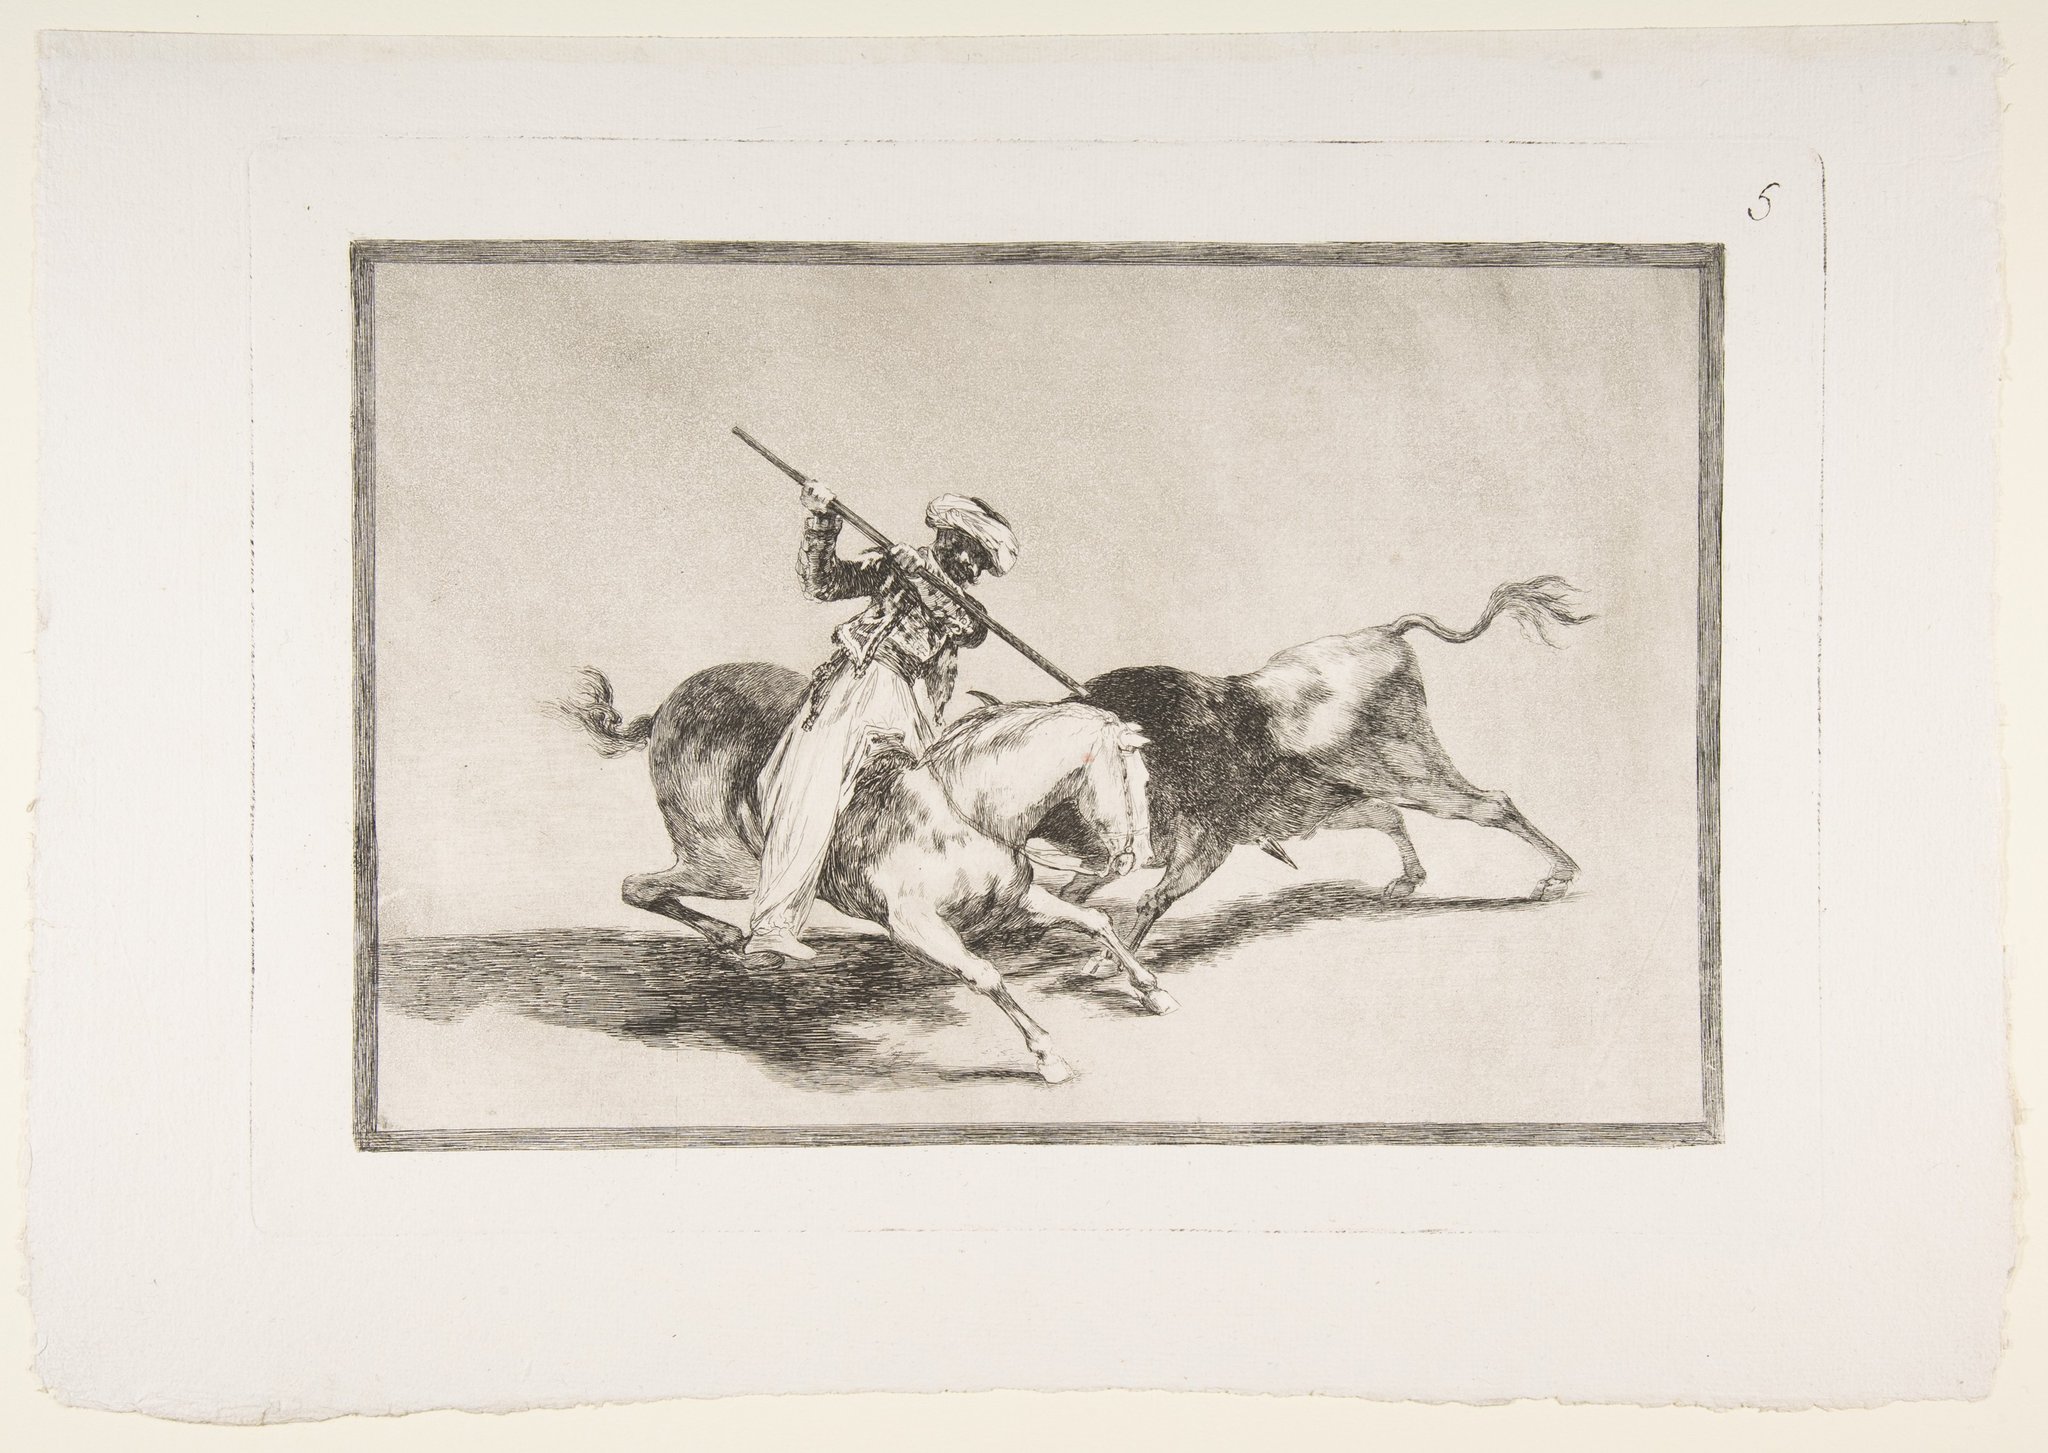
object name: print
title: Plate 5 from "La Tauromaquia": The spirited Moor Gazul is the first to spear bulls according to the rules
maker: goya (francisco de goya y lucientes)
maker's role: artist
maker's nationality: spanish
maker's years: 1746-1828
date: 1816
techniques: aquatint, burnishing, drypoint, etching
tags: spears,men,bulls,horses